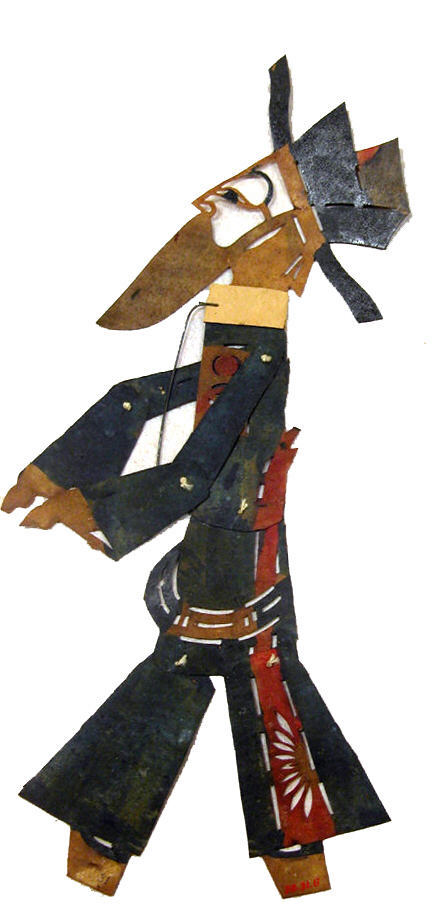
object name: shadow player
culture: chinese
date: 1801-1900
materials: cord, skin